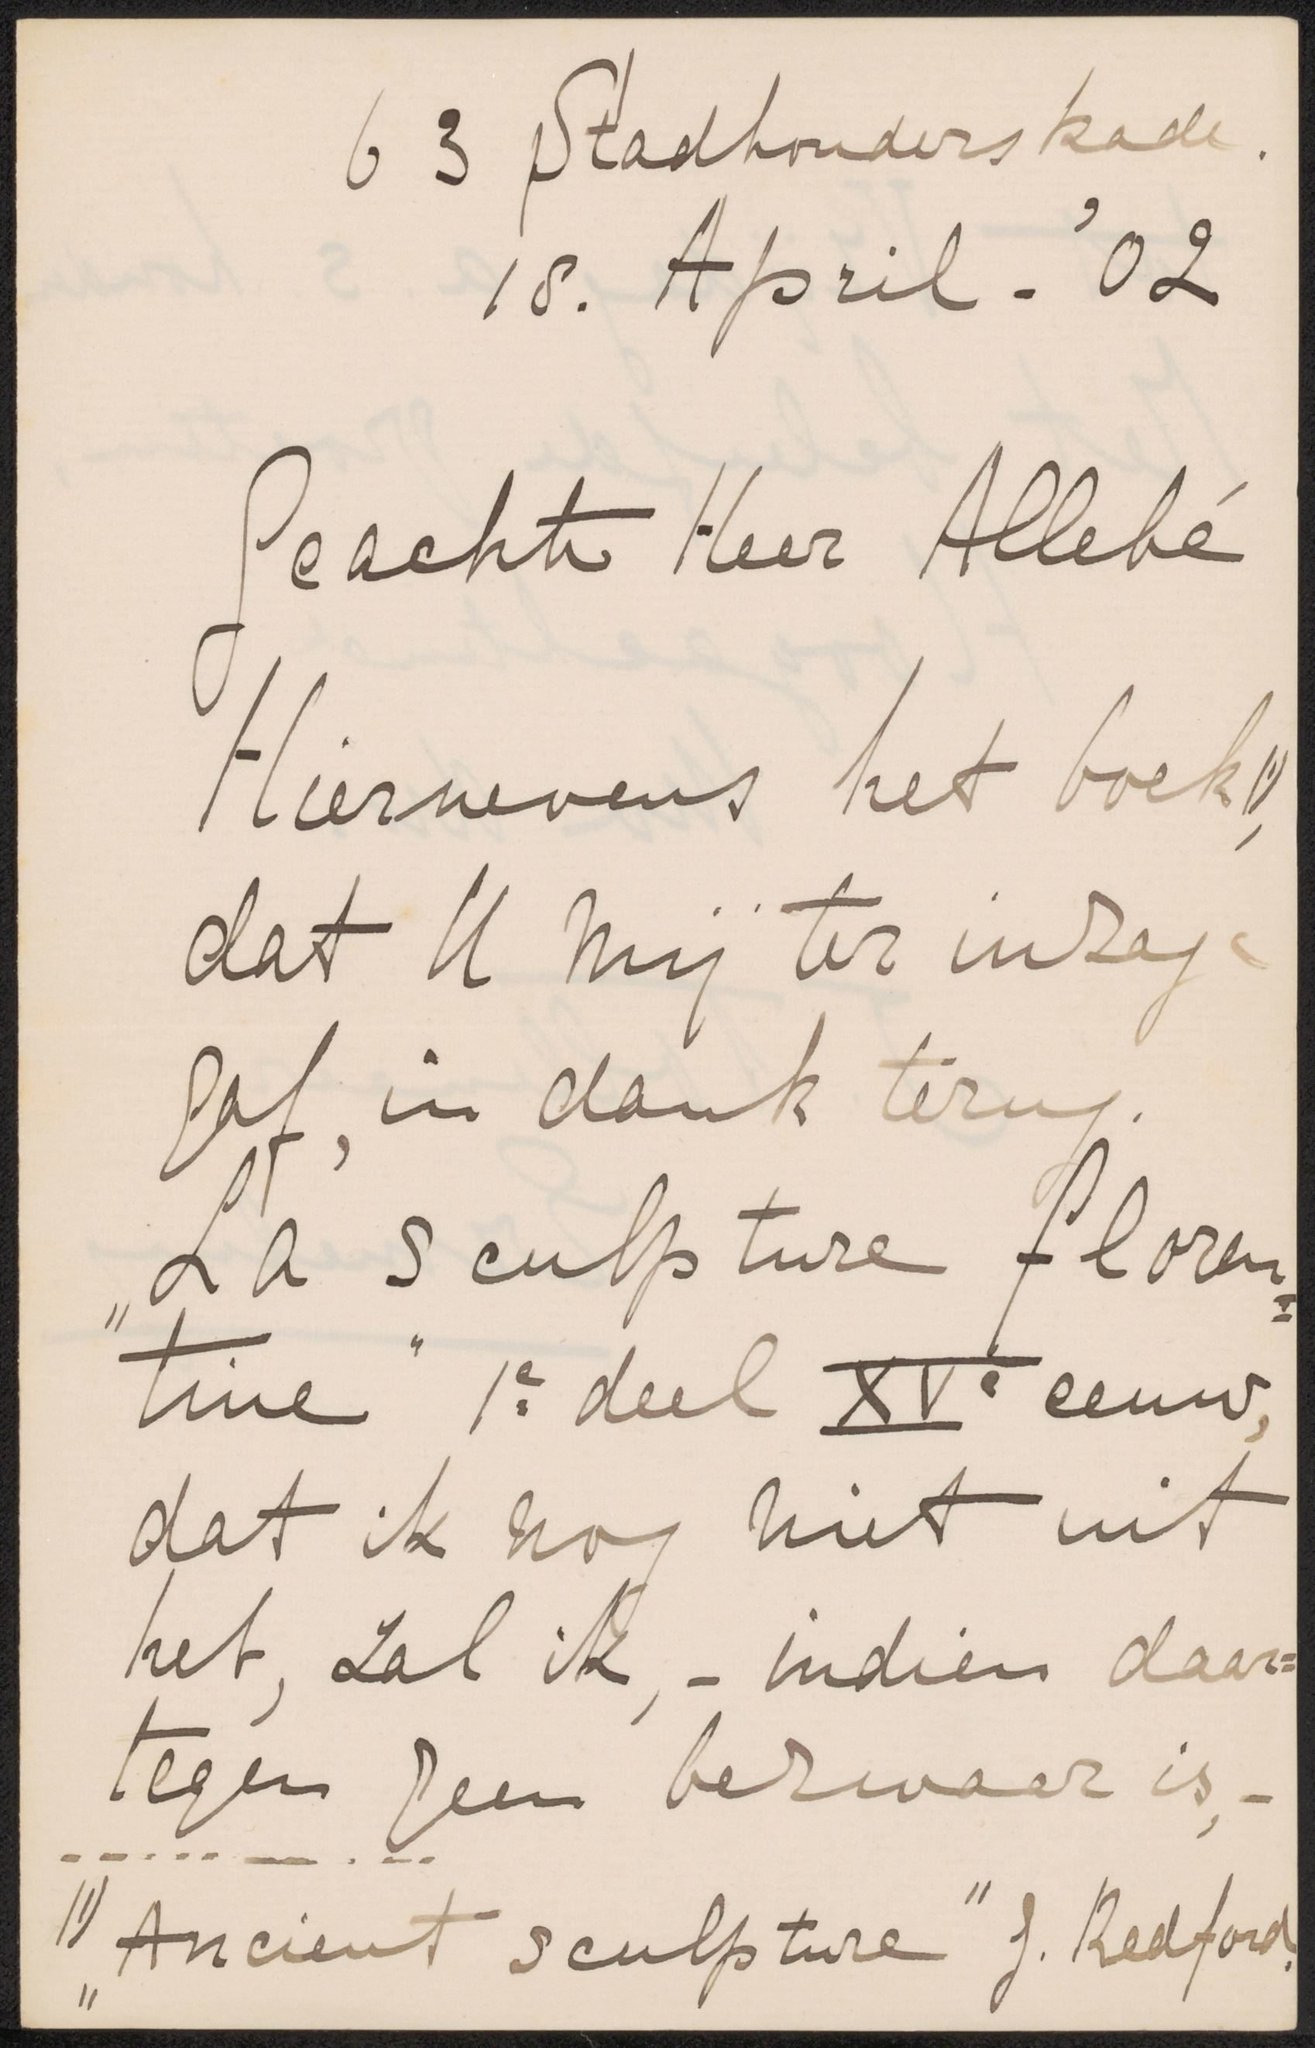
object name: letter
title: Brief aan August Allebé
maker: annie ermeling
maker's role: draughtsman, print maker, sculptor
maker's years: 1865-1932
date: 1902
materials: ink, paper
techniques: pen, writing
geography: amsterdam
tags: amsterdam, print maker, draughtsman, august allebé